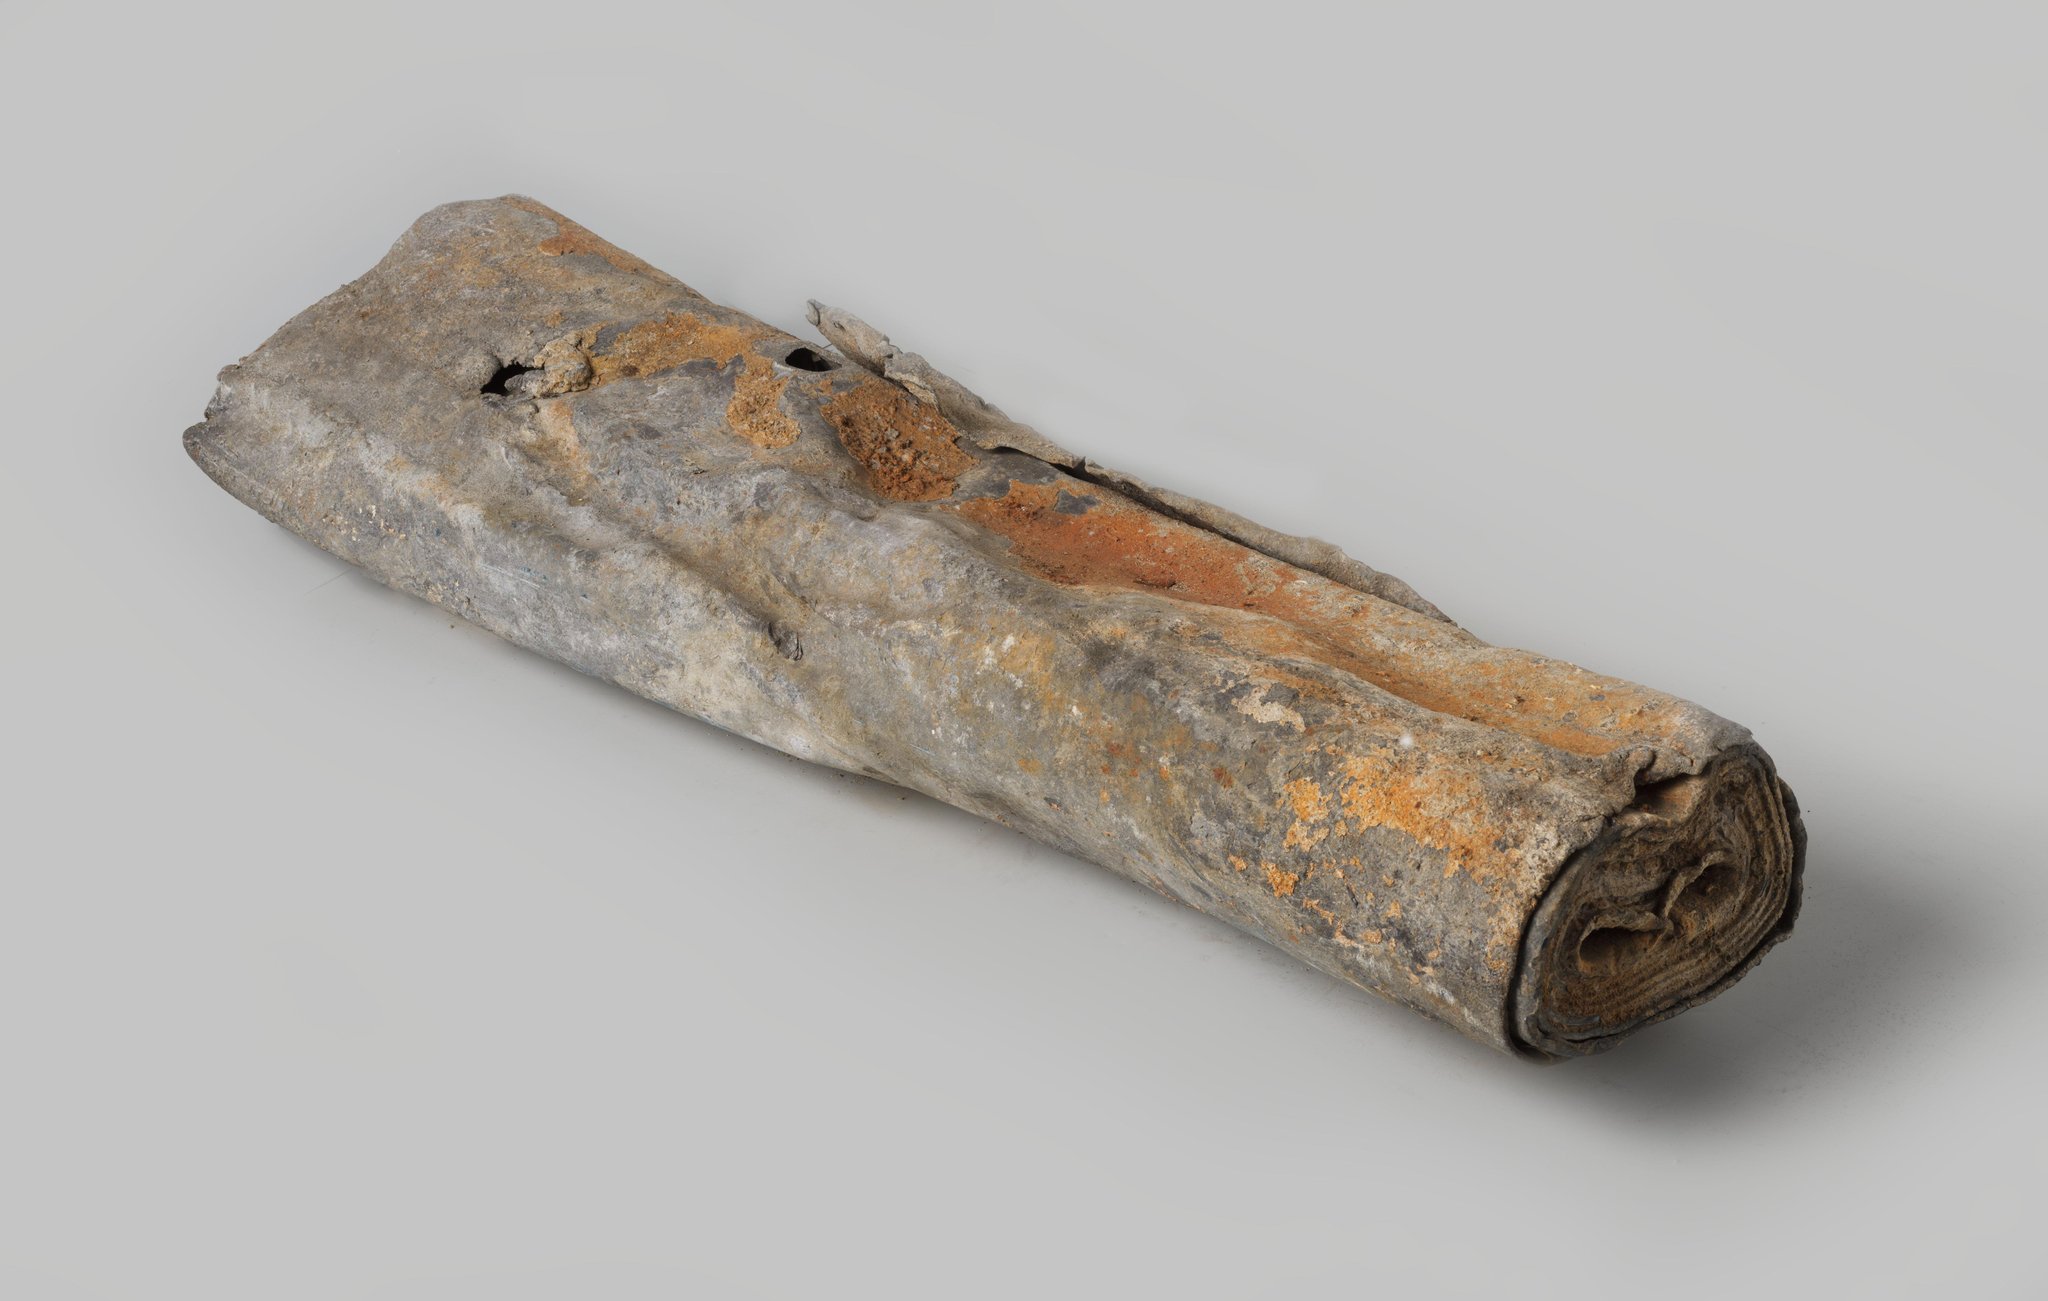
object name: sheet lead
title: Rol lood uit het wrak van de Oost-Indiëvaarder Hollandia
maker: Anonymous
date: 1700-1743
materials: lead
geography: netherlands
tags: verenigde oostindische compagnie, hollandia (schip), annet